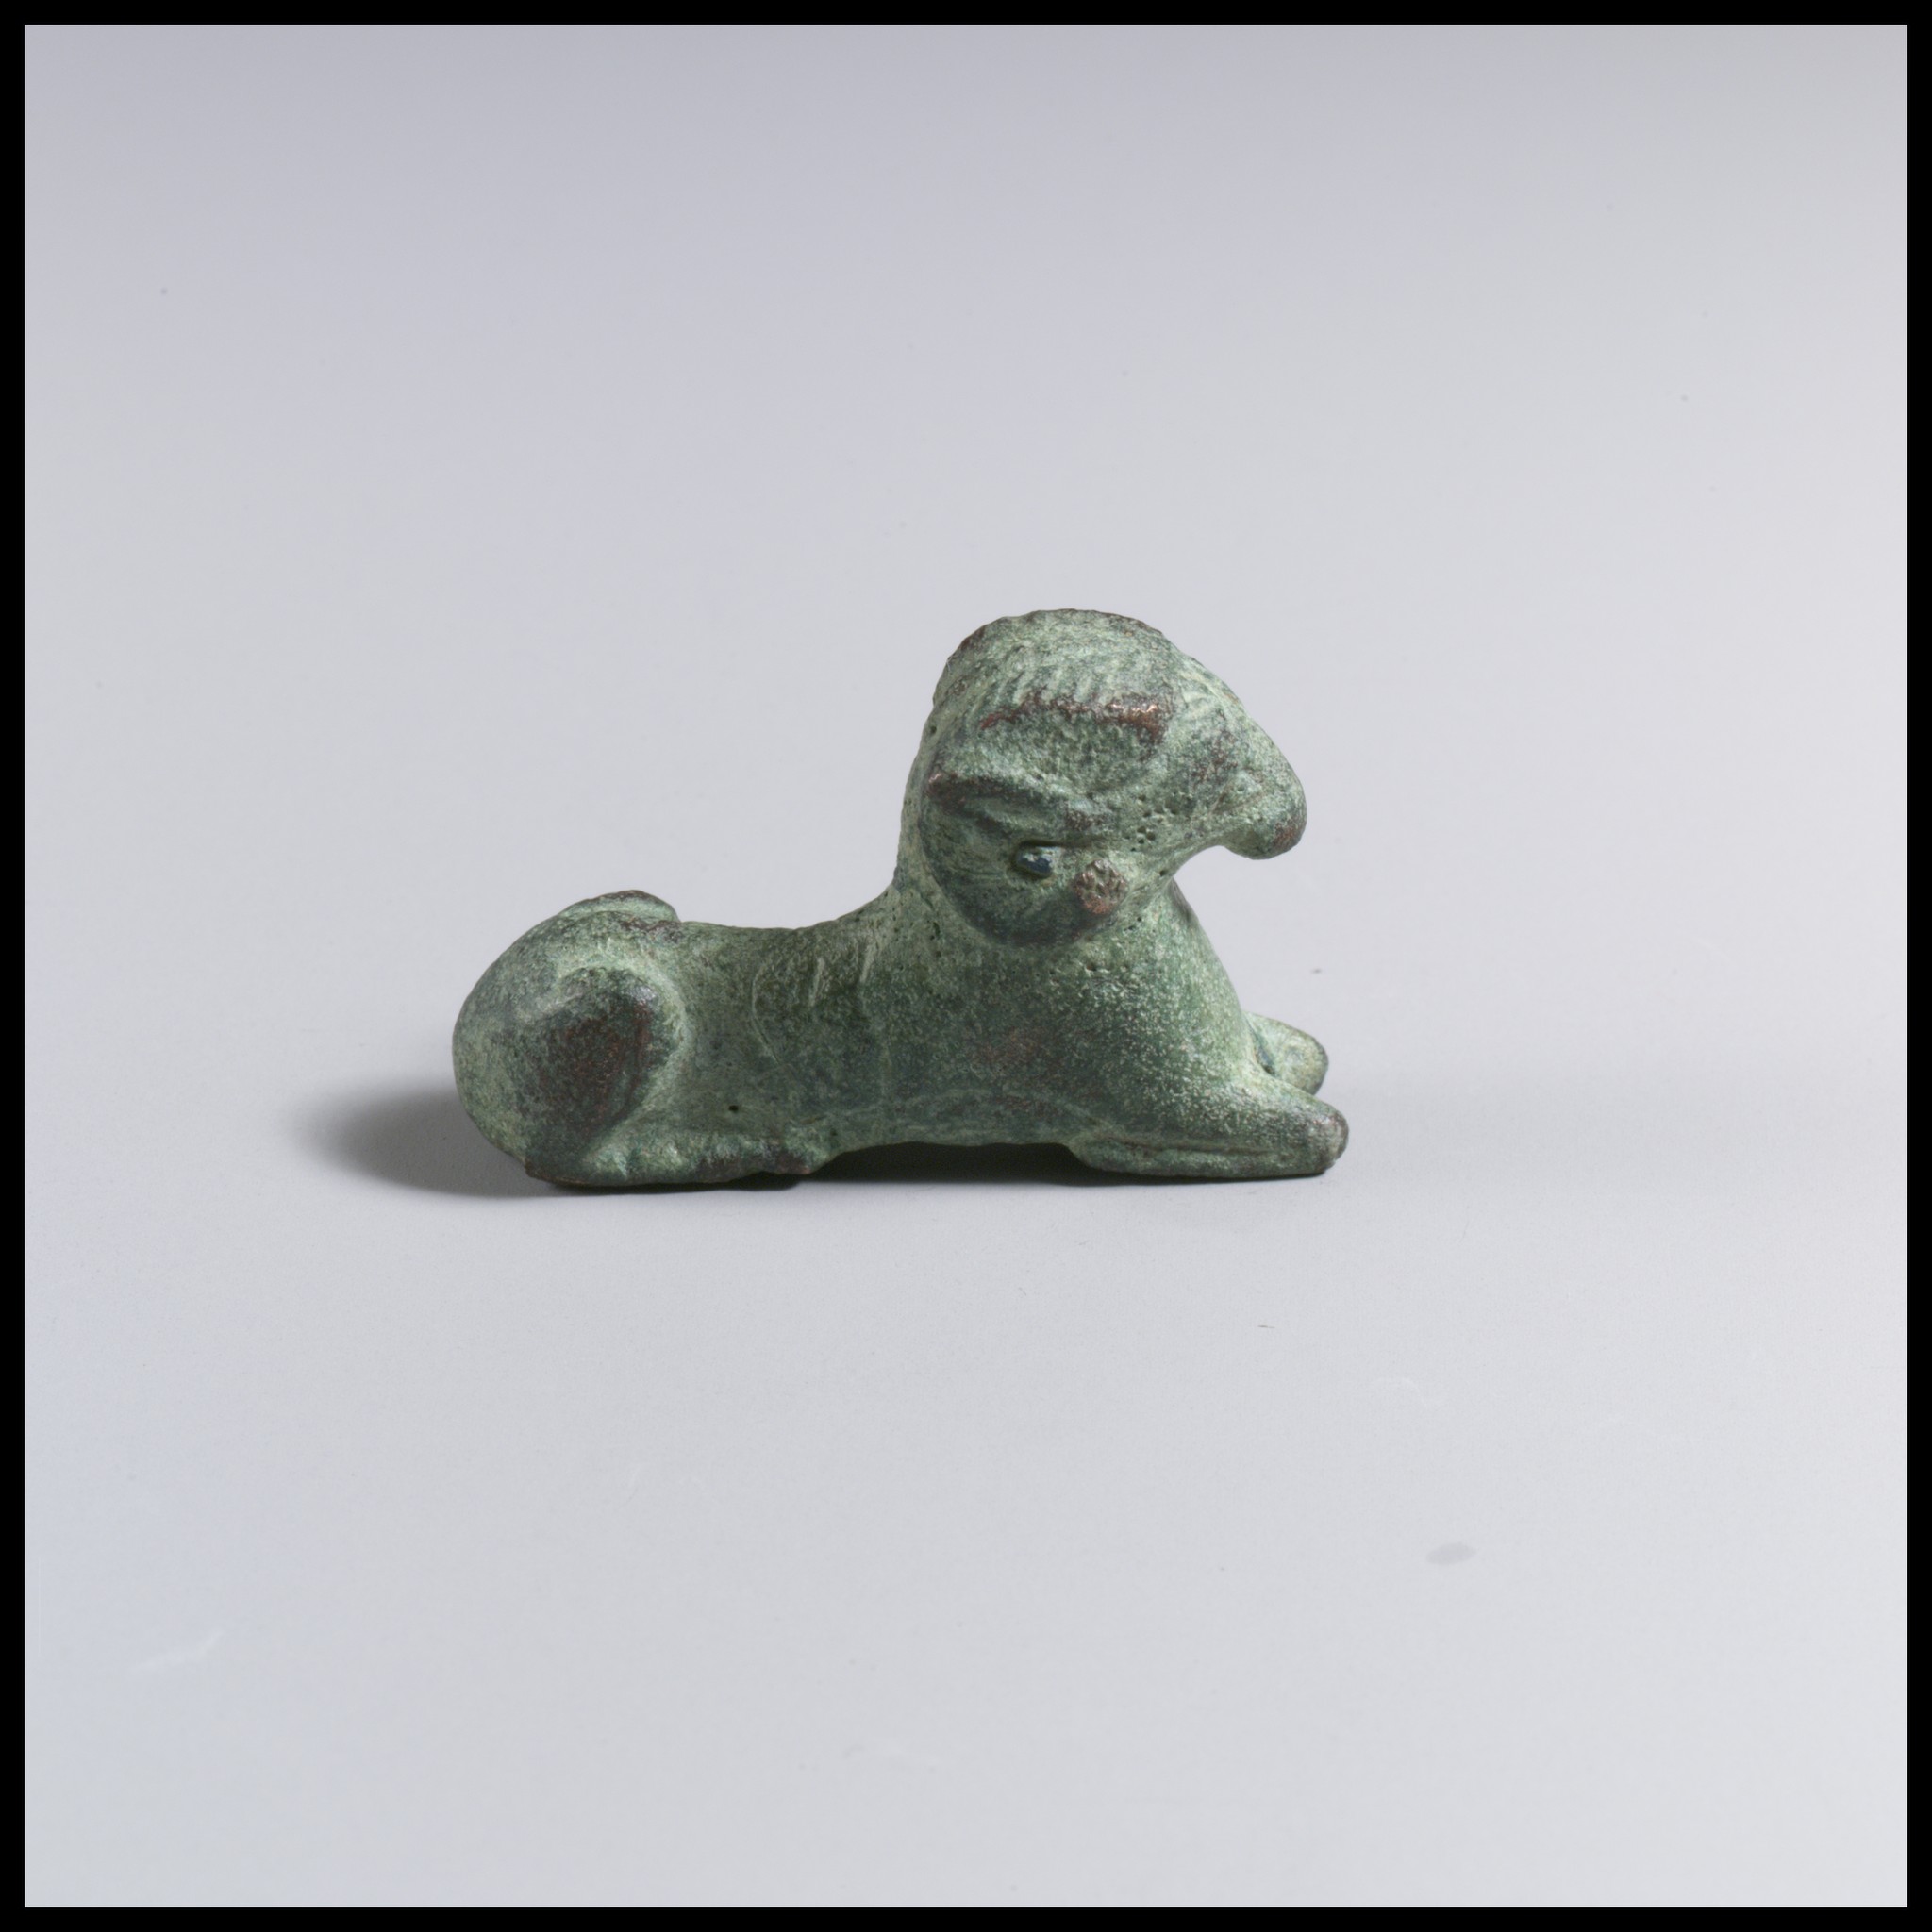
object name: statuette of a ram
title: Bronze statuette of a ram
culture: roman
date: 1-200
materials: bronze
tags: rams